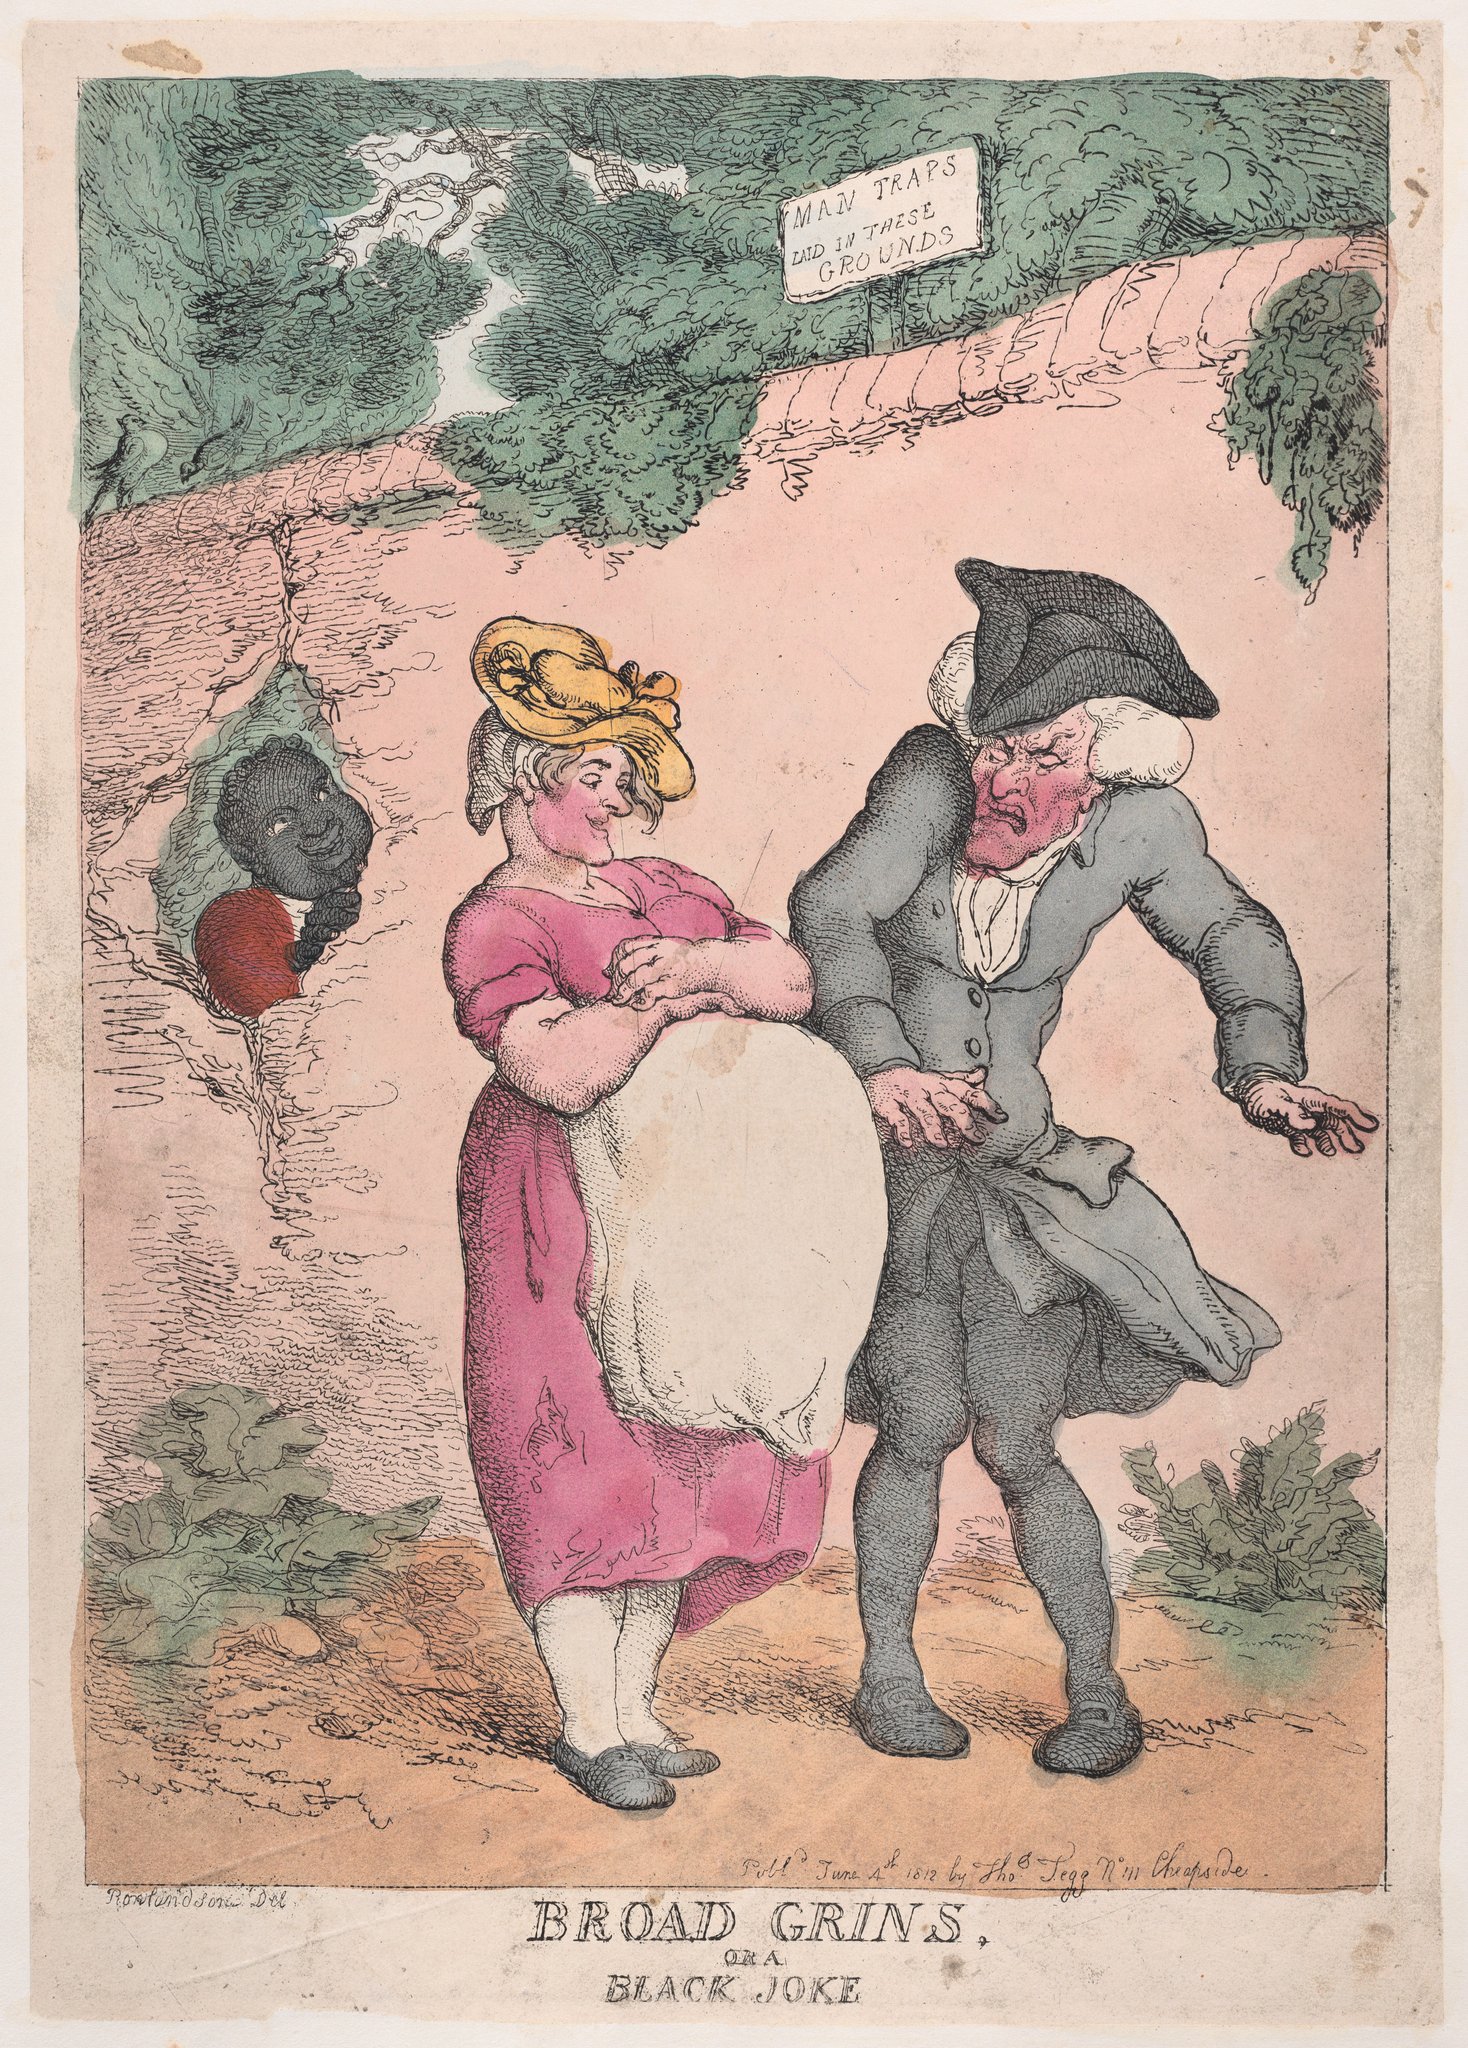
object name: print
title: Broad Grins, or a Black Joke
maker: thomas rowlandson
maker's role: artist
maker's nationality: british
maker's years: 1757-1827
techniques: etching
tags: satire,men,women